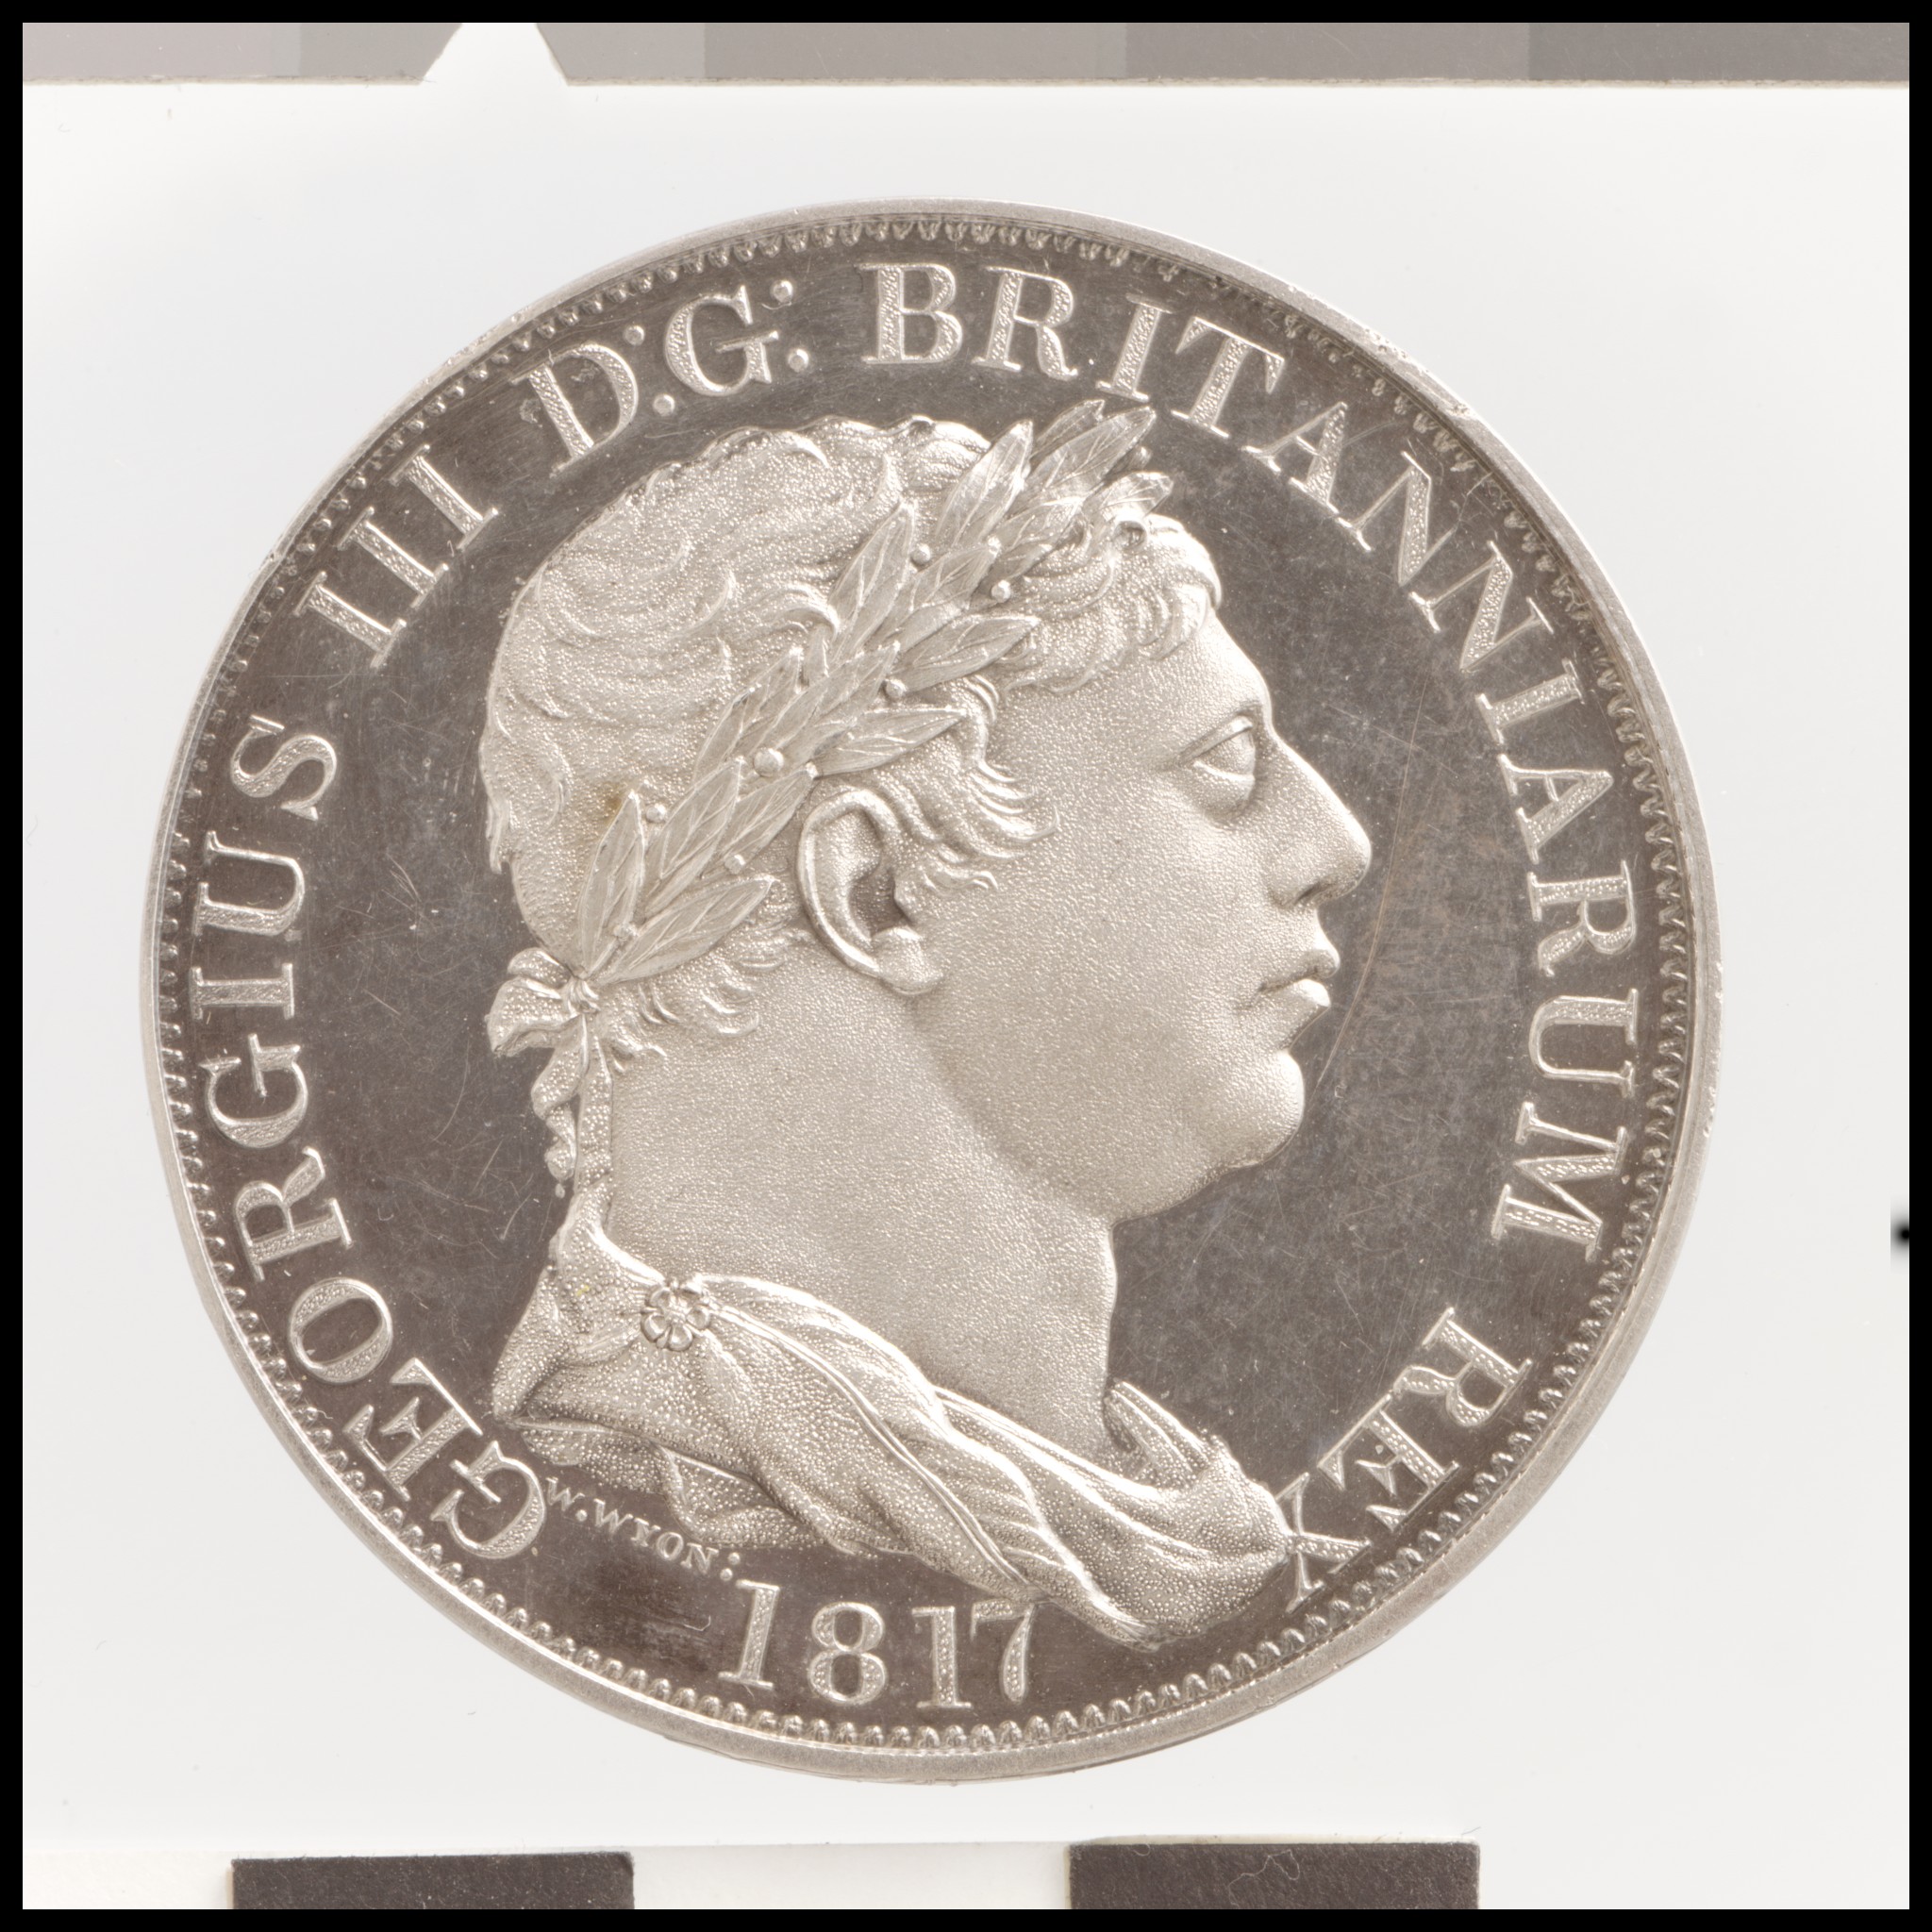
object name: crown coin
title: George III "Incorrupta" crown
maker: william wyon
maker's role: artist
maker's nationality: british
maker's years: 1795-1851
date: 1817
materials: silver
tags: men,profiles,coat of arms